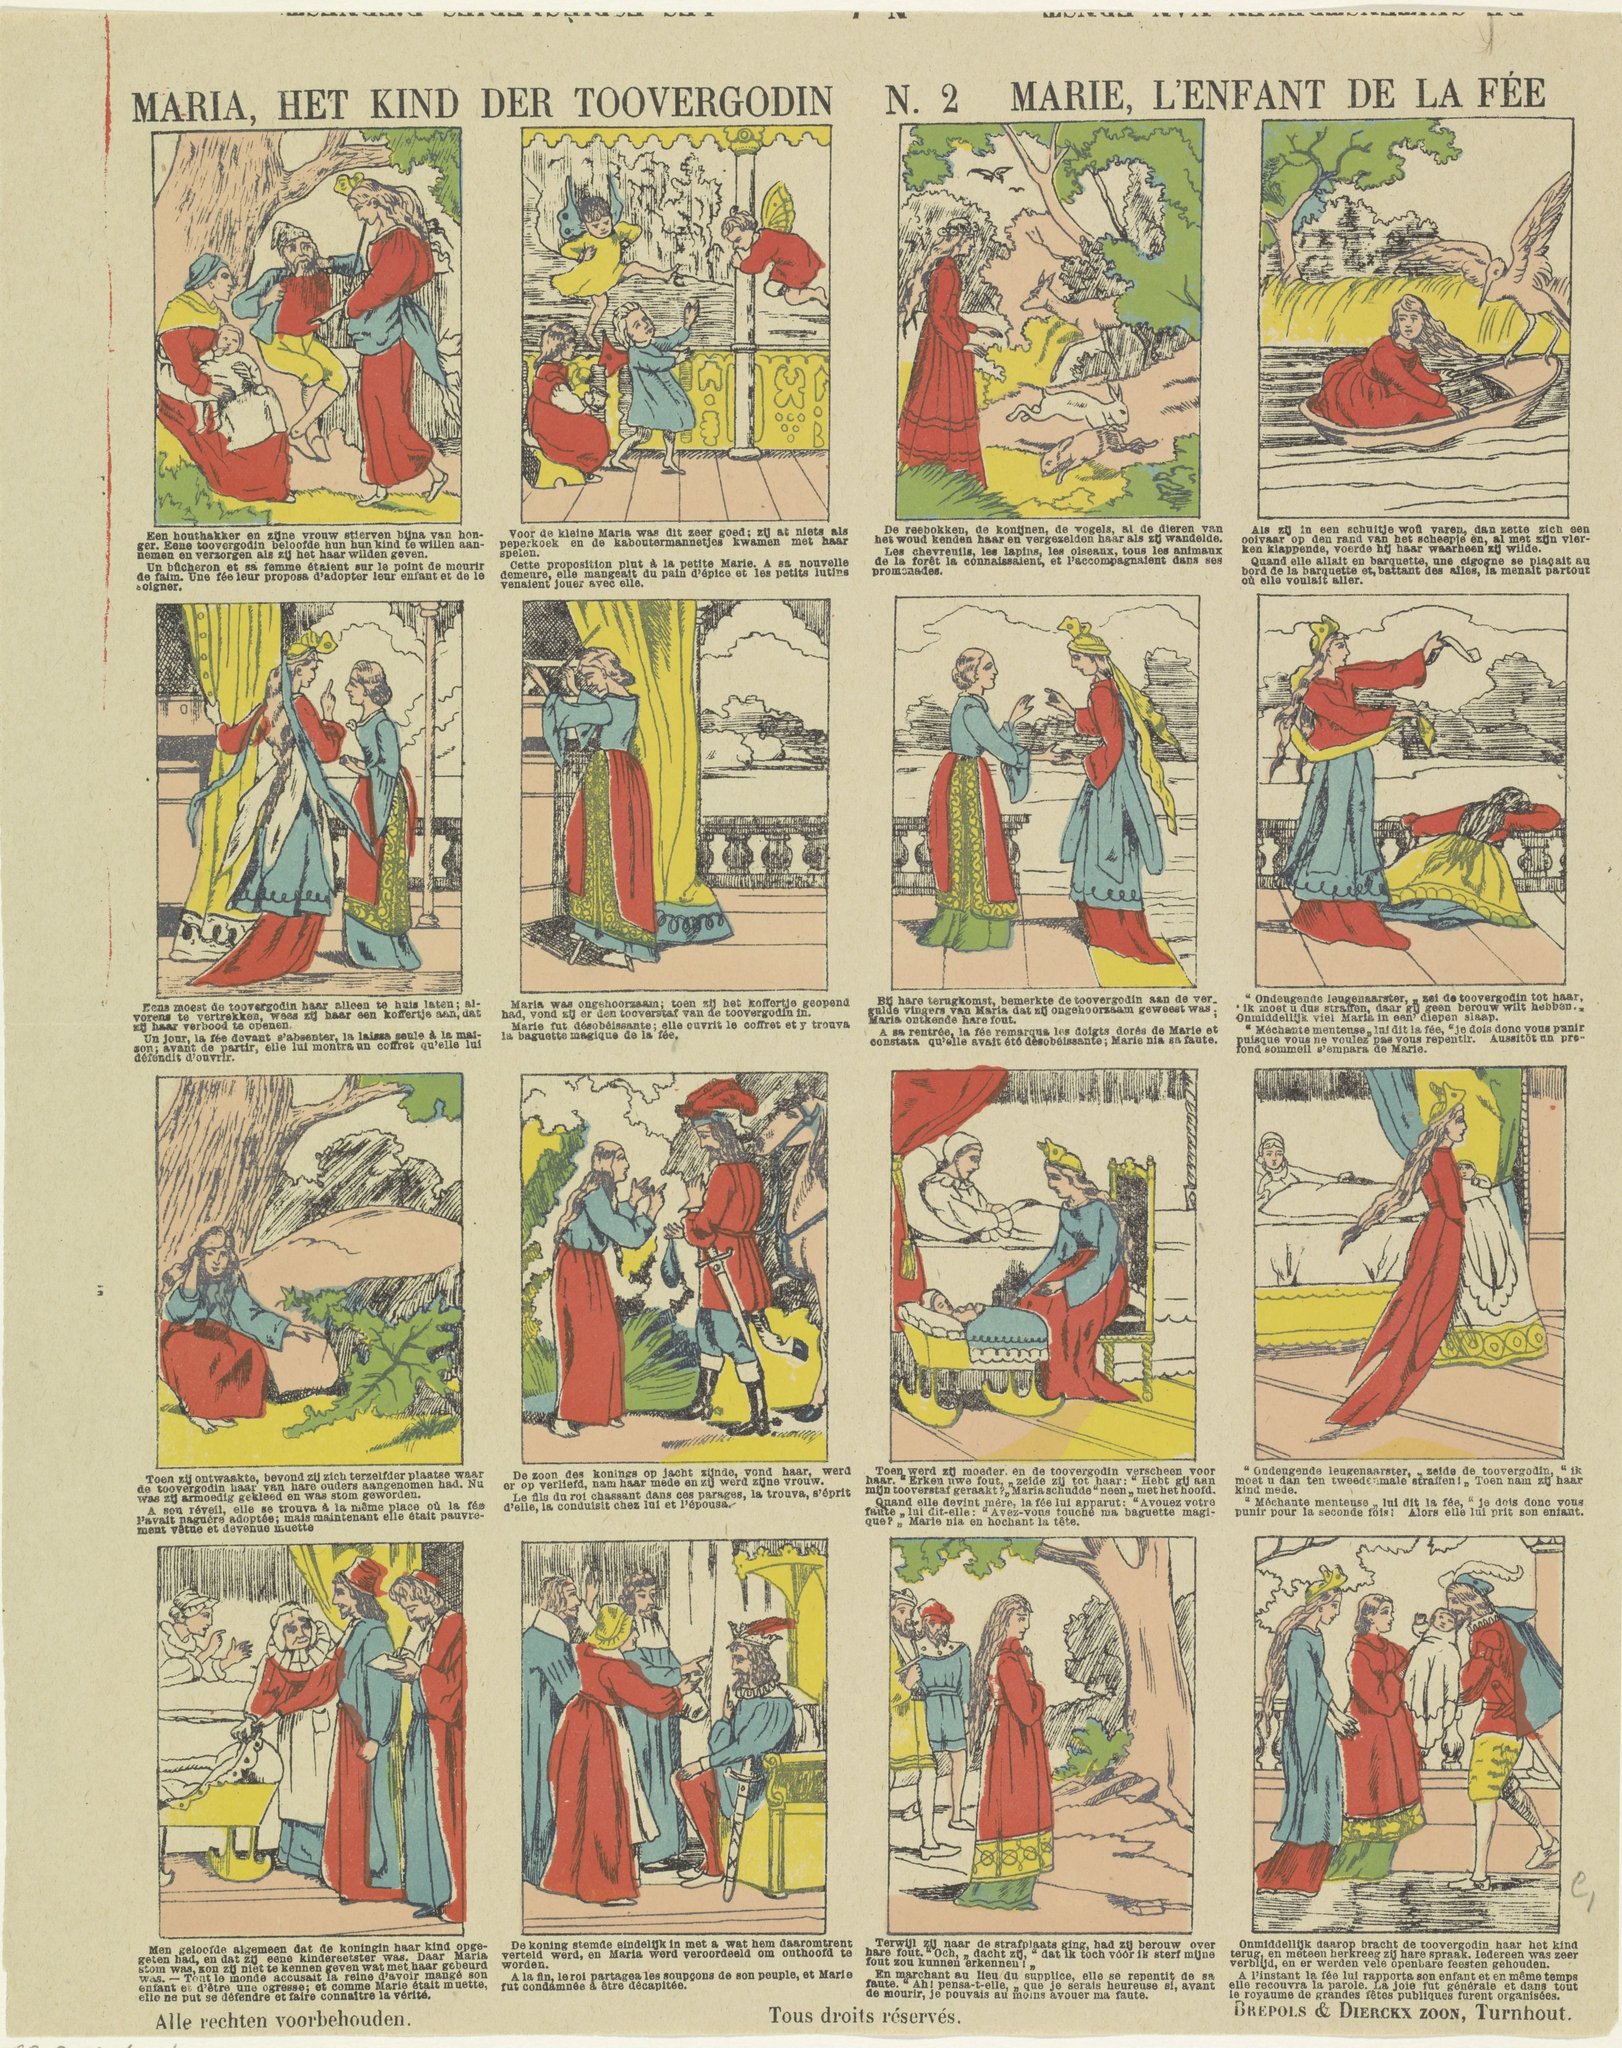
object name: print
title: Maria, het kind der toovergodin / Marie, l'enfant de la fée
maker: Anonymous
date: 1833-1906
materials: paper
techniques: lithograph, letterpress printing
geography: turnhout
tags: tales and fairy tales, representations ~ goddesses, demi-goddesses, heroines, etc. (non-christian religions)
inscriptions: collector's mark: Lugt 2228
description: Blad met 16 voorstellingen uit het sprookje van Maria, het kind van een tovergodin. Onder elke afbeelding een onderschrift in het Nederlands en in het Frans. Genummerd midden boven: N. 2.